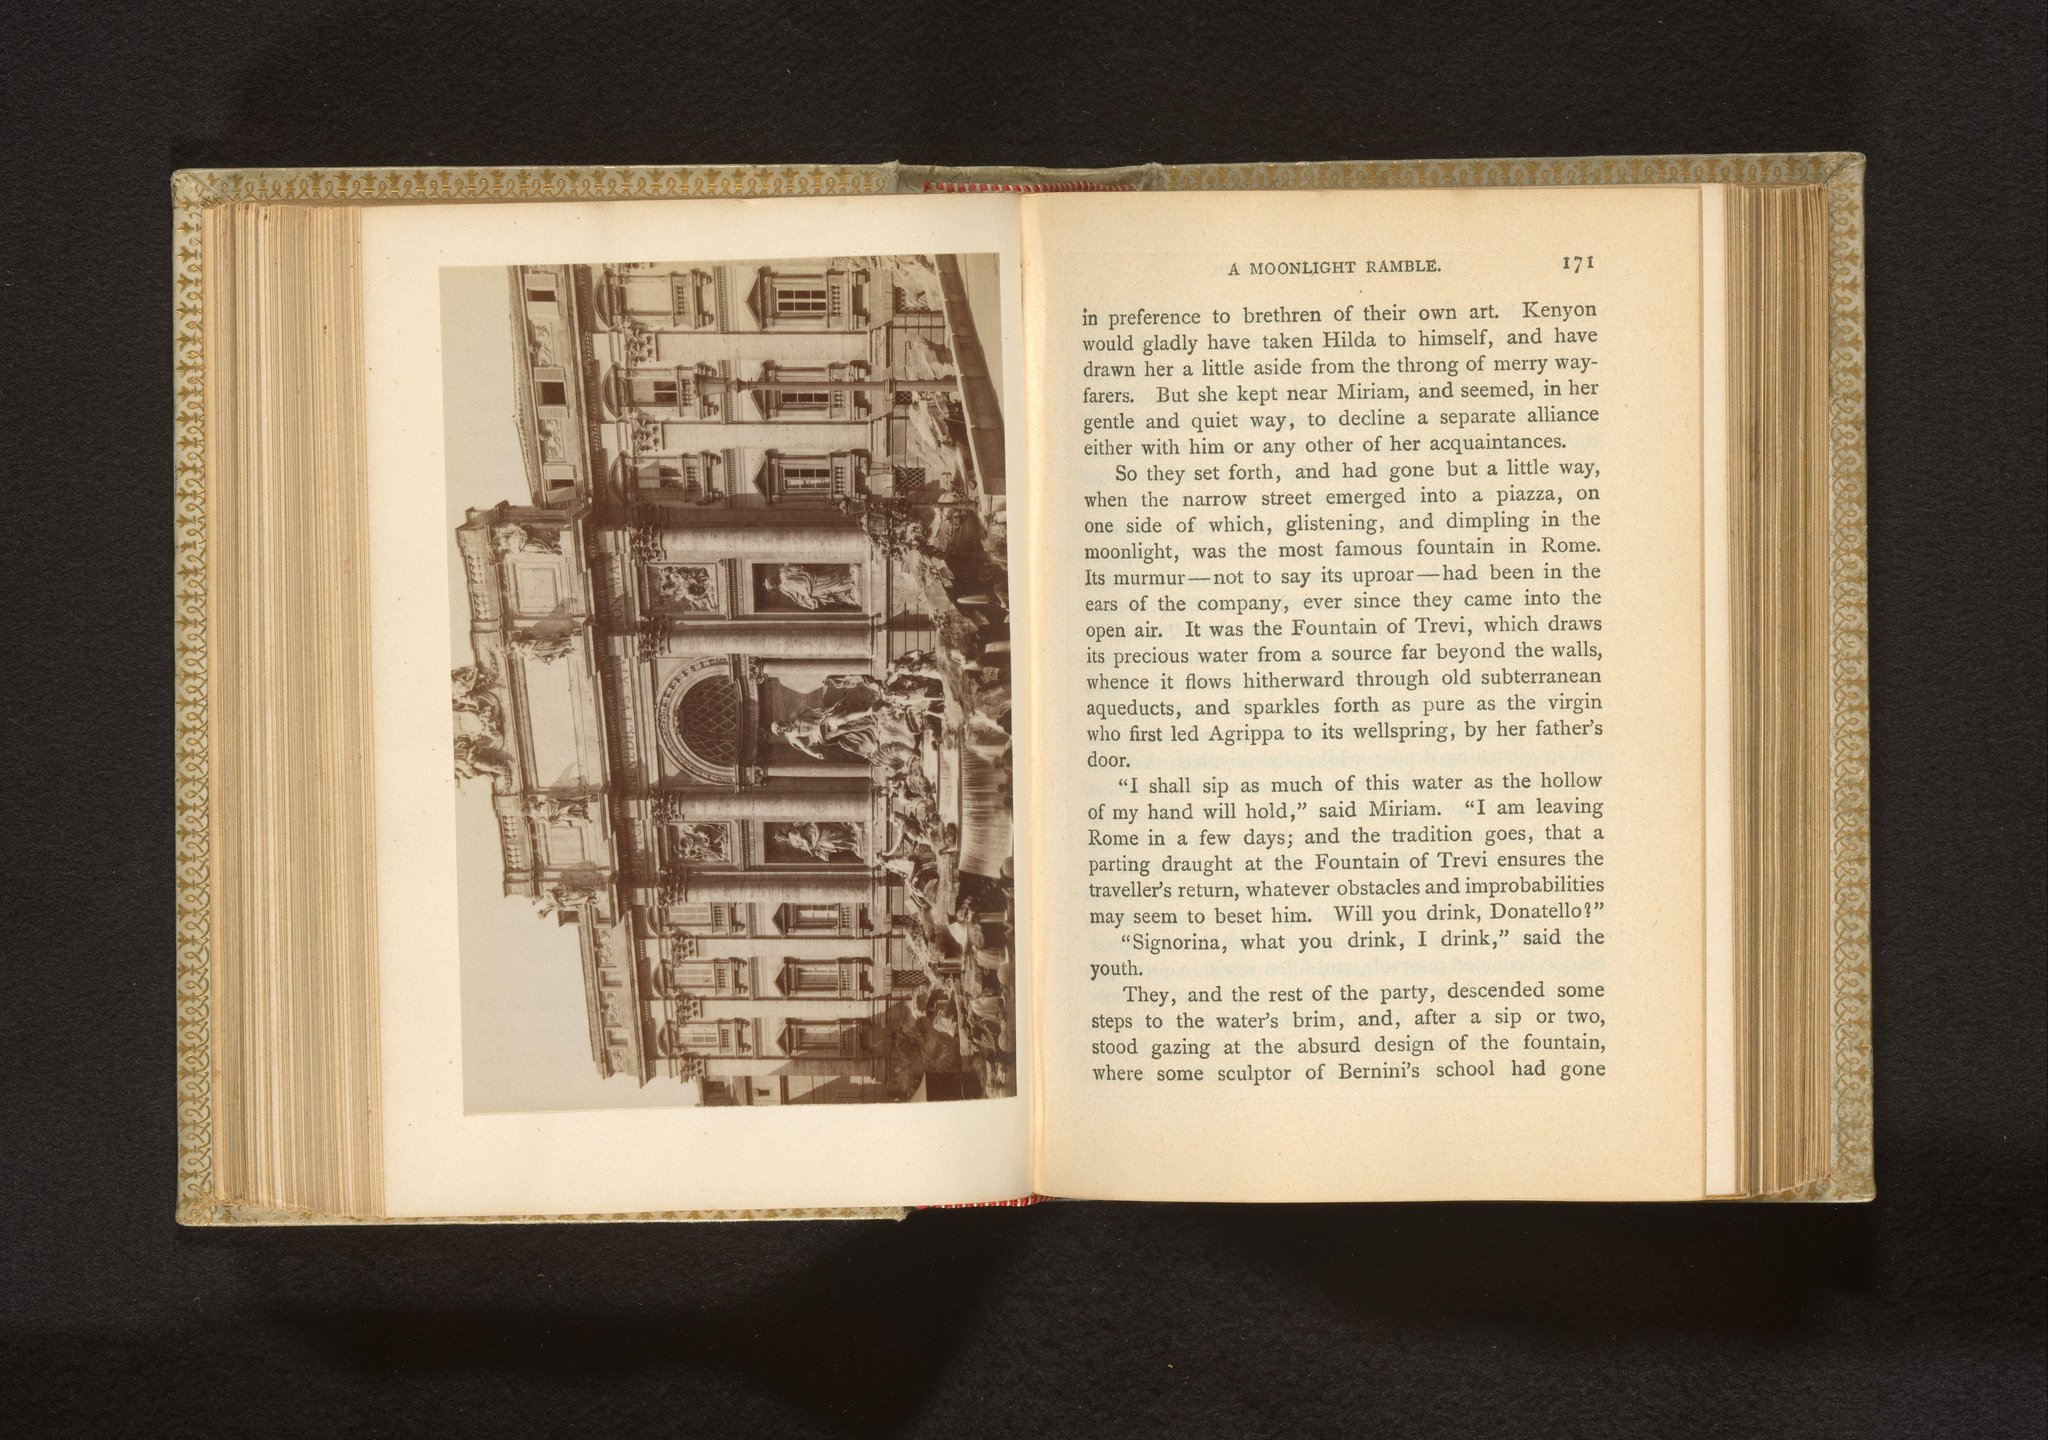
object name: page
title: Gezicht op de Trevifontein in Rome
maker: Anonymous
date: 1850-1860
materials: photographic support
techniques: albumen print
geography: rome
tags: ornamental fountain